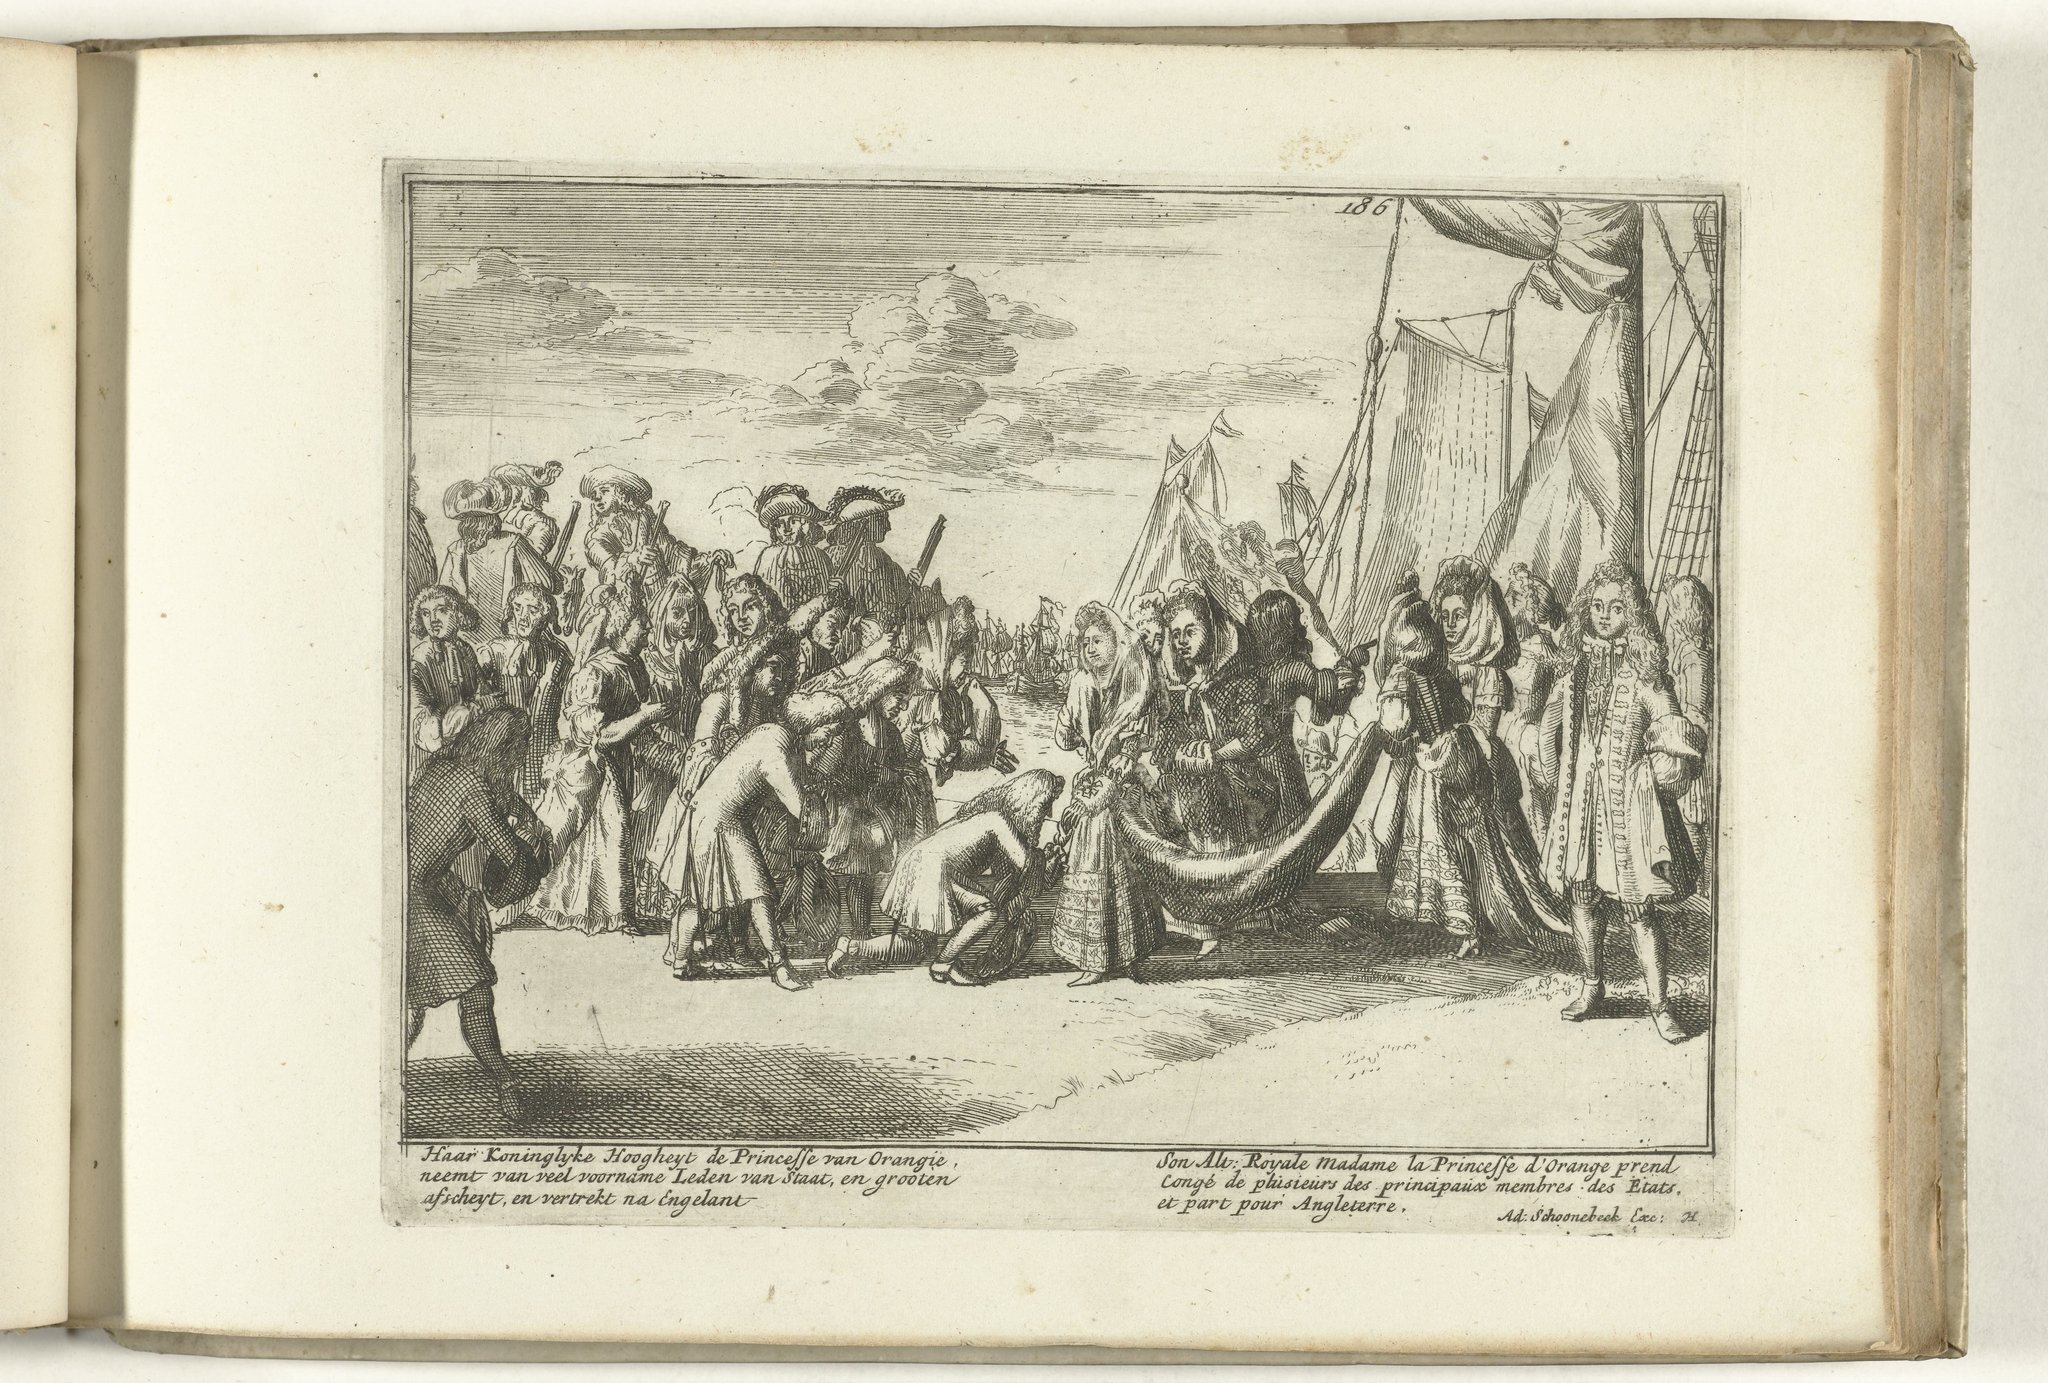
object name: print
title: Prinses Maria neemt afscheid bij haar vertrek naar Engeland, 1689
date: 1689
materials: paper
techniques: etching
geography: amsterdam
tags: london, maria ii stuart (koningin van engeland, schotland en ierland), arrival and return ~ travelling, brielle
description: De prinses van Oranje Maria II Stuart neemt afscheid van regeringsvertegenwoordigers bij haar vertrek vanuit Brielle op 20 februari 1689 naar Engeland. Genummerd rechtsboven: 186. Plaat H in de serie 'Engelants schouwtoneel' over de Glorious Revolution 1688-1689 (tweede deel). Met onderschriften in het Nederlands en Frans.